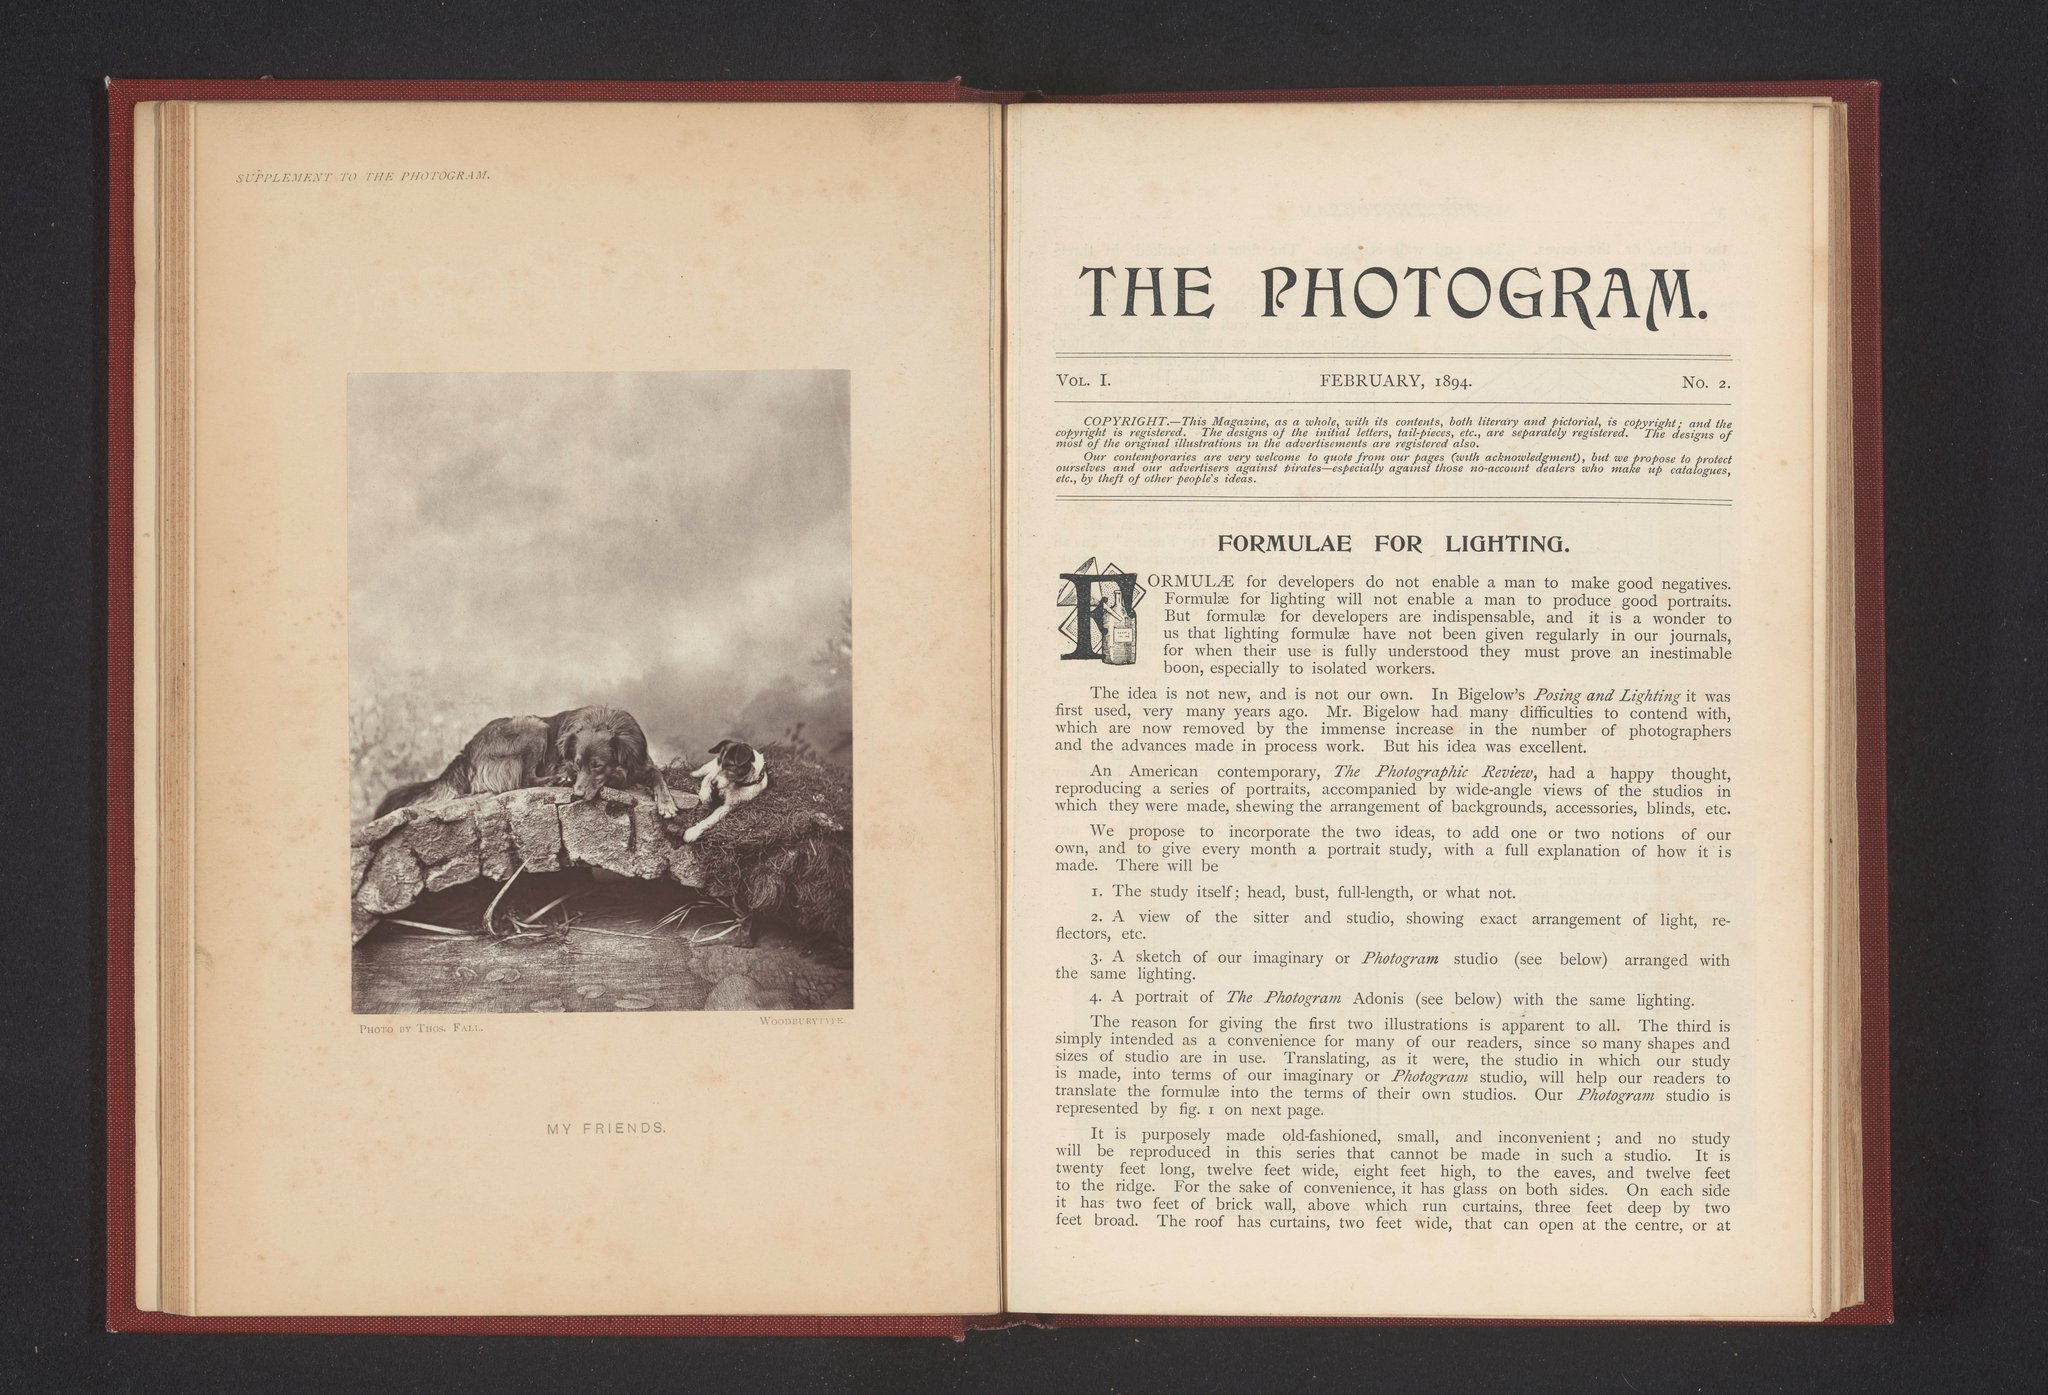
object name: page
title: My friends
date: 1889-1894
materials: paper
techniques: woodburytype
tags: dog